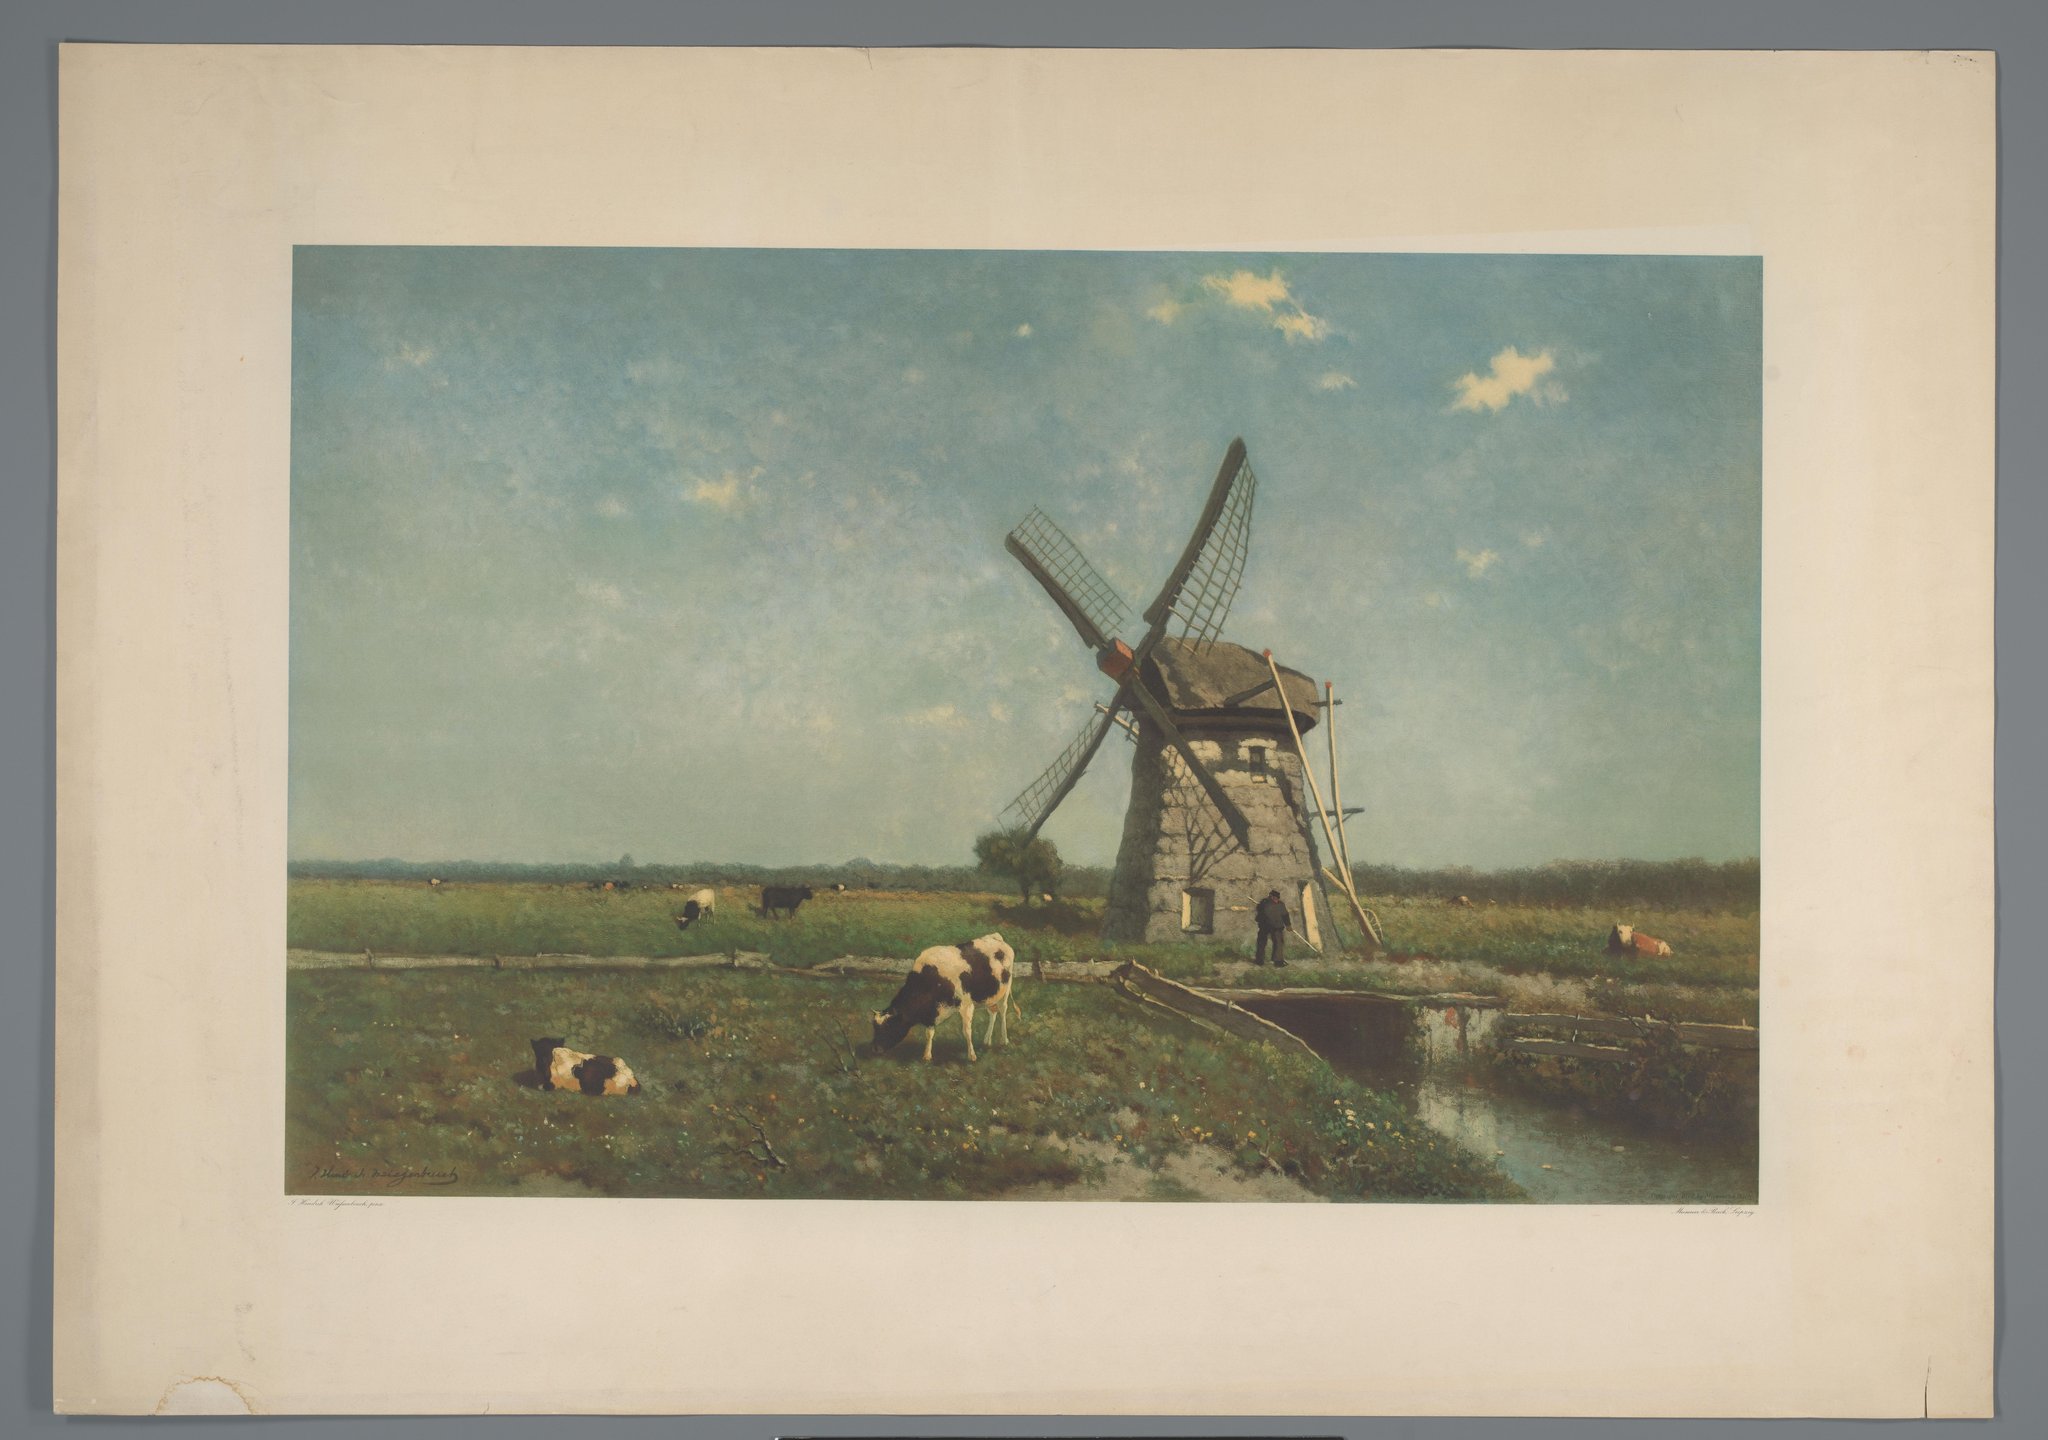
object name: reproduction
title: Fotoreproductie van Landschap met molen bij Schiedam door Jan Hendrik Weissenbruch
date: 1861-1914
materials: cardboard, paper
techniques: collotype process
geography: leipzig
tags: cow, windmill in landscape, picture, painting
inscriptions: inscription: ‘'14 124’, inscription: ‘'04. 179.’, inscription, gestempeld: ‘R: MVS.’, inscription: ‘J. Hendrik Weifsenbruch, pinx.’, inscription: ‘Meissner & Buch, Leipzig’, inscription: ‘Schilderij Boijmans Rotterdam’, label: ‘No 376/ H. J. Weissebruch/ ,,Somerstimmung in Holland"/ Bilgrösse: 48,5:75 cm./ Verlag: Meissner & Buch, Leipzig.’